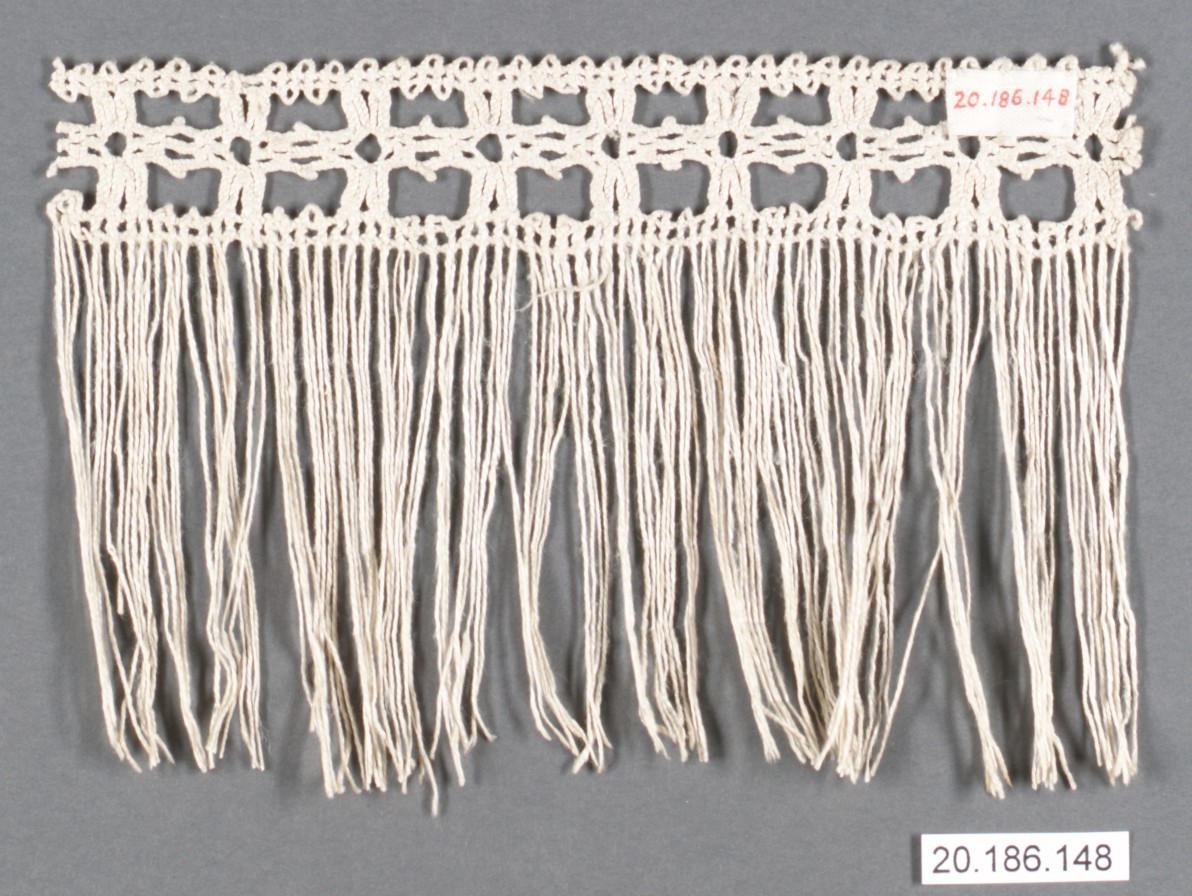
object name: edging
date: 1501-1600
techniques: lace